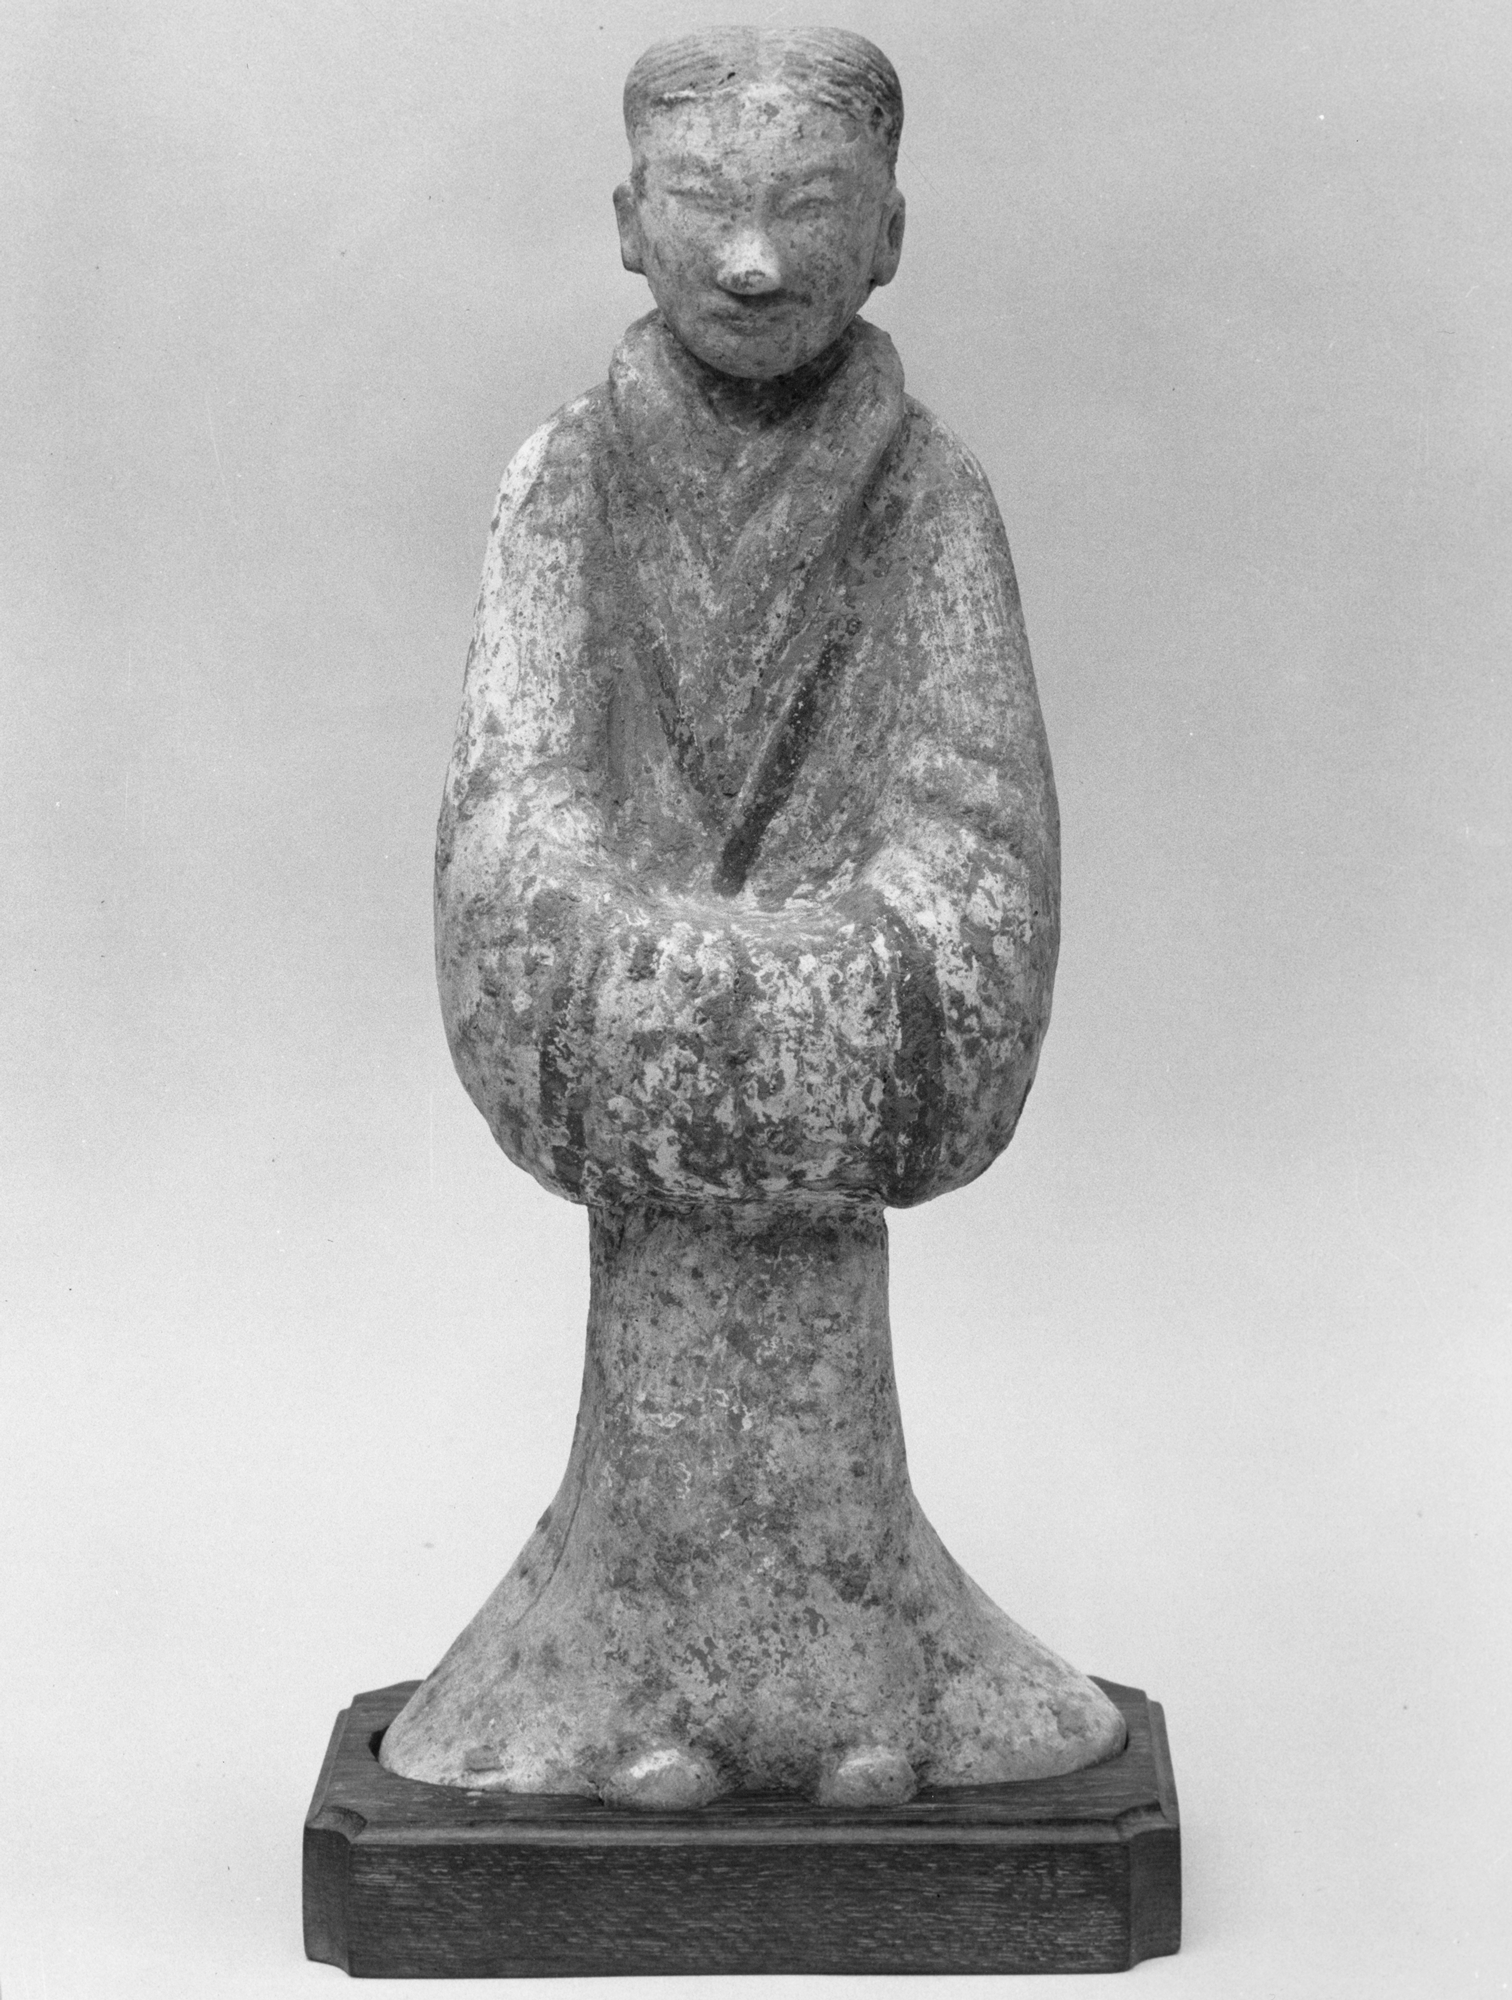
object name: figure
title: Figure of a Man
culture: chinese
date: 25-220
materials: pottery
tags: men